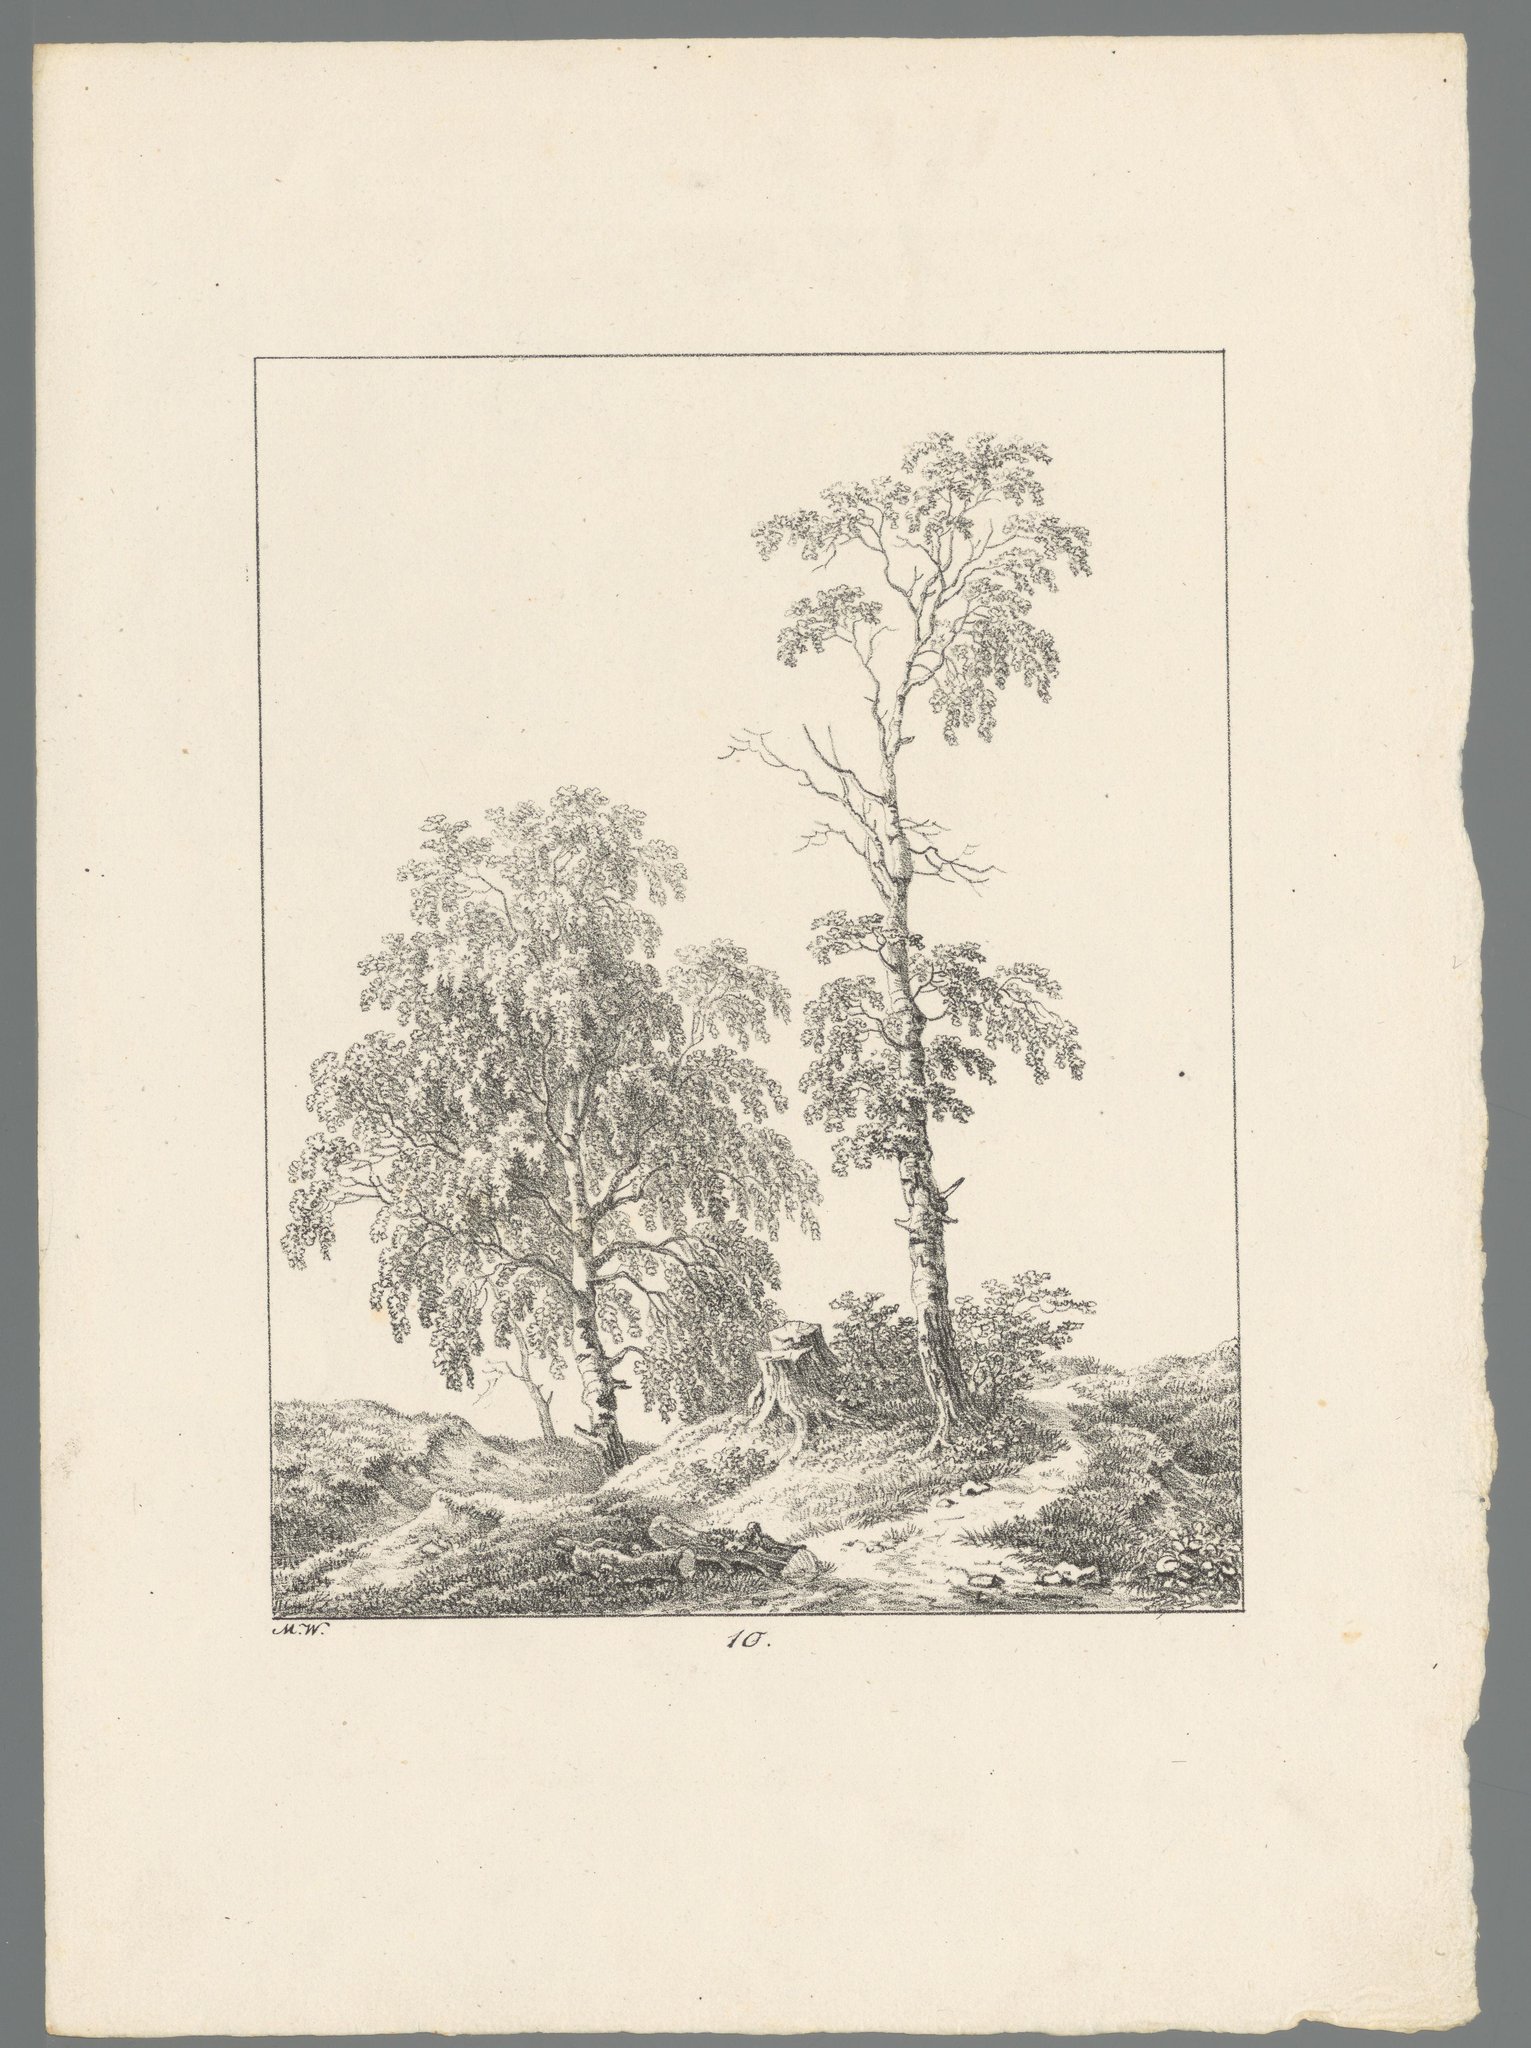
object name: print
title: Voorbeelden voor landschapstekenaars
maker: max josef wagenbauer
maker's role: print maker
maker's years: 1774-1829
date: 1823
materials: paper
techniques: lithograph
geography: munich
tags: trees, landscapes in the temperate zone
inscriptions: collector's mark: Lugt 2760, collector's mark: Lugt 2228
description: Prent behoort tot het eerste deel van de serie 'Vorlagen für Landschaft-zeichner'. Dit eerste deel bevat twintig prenten.